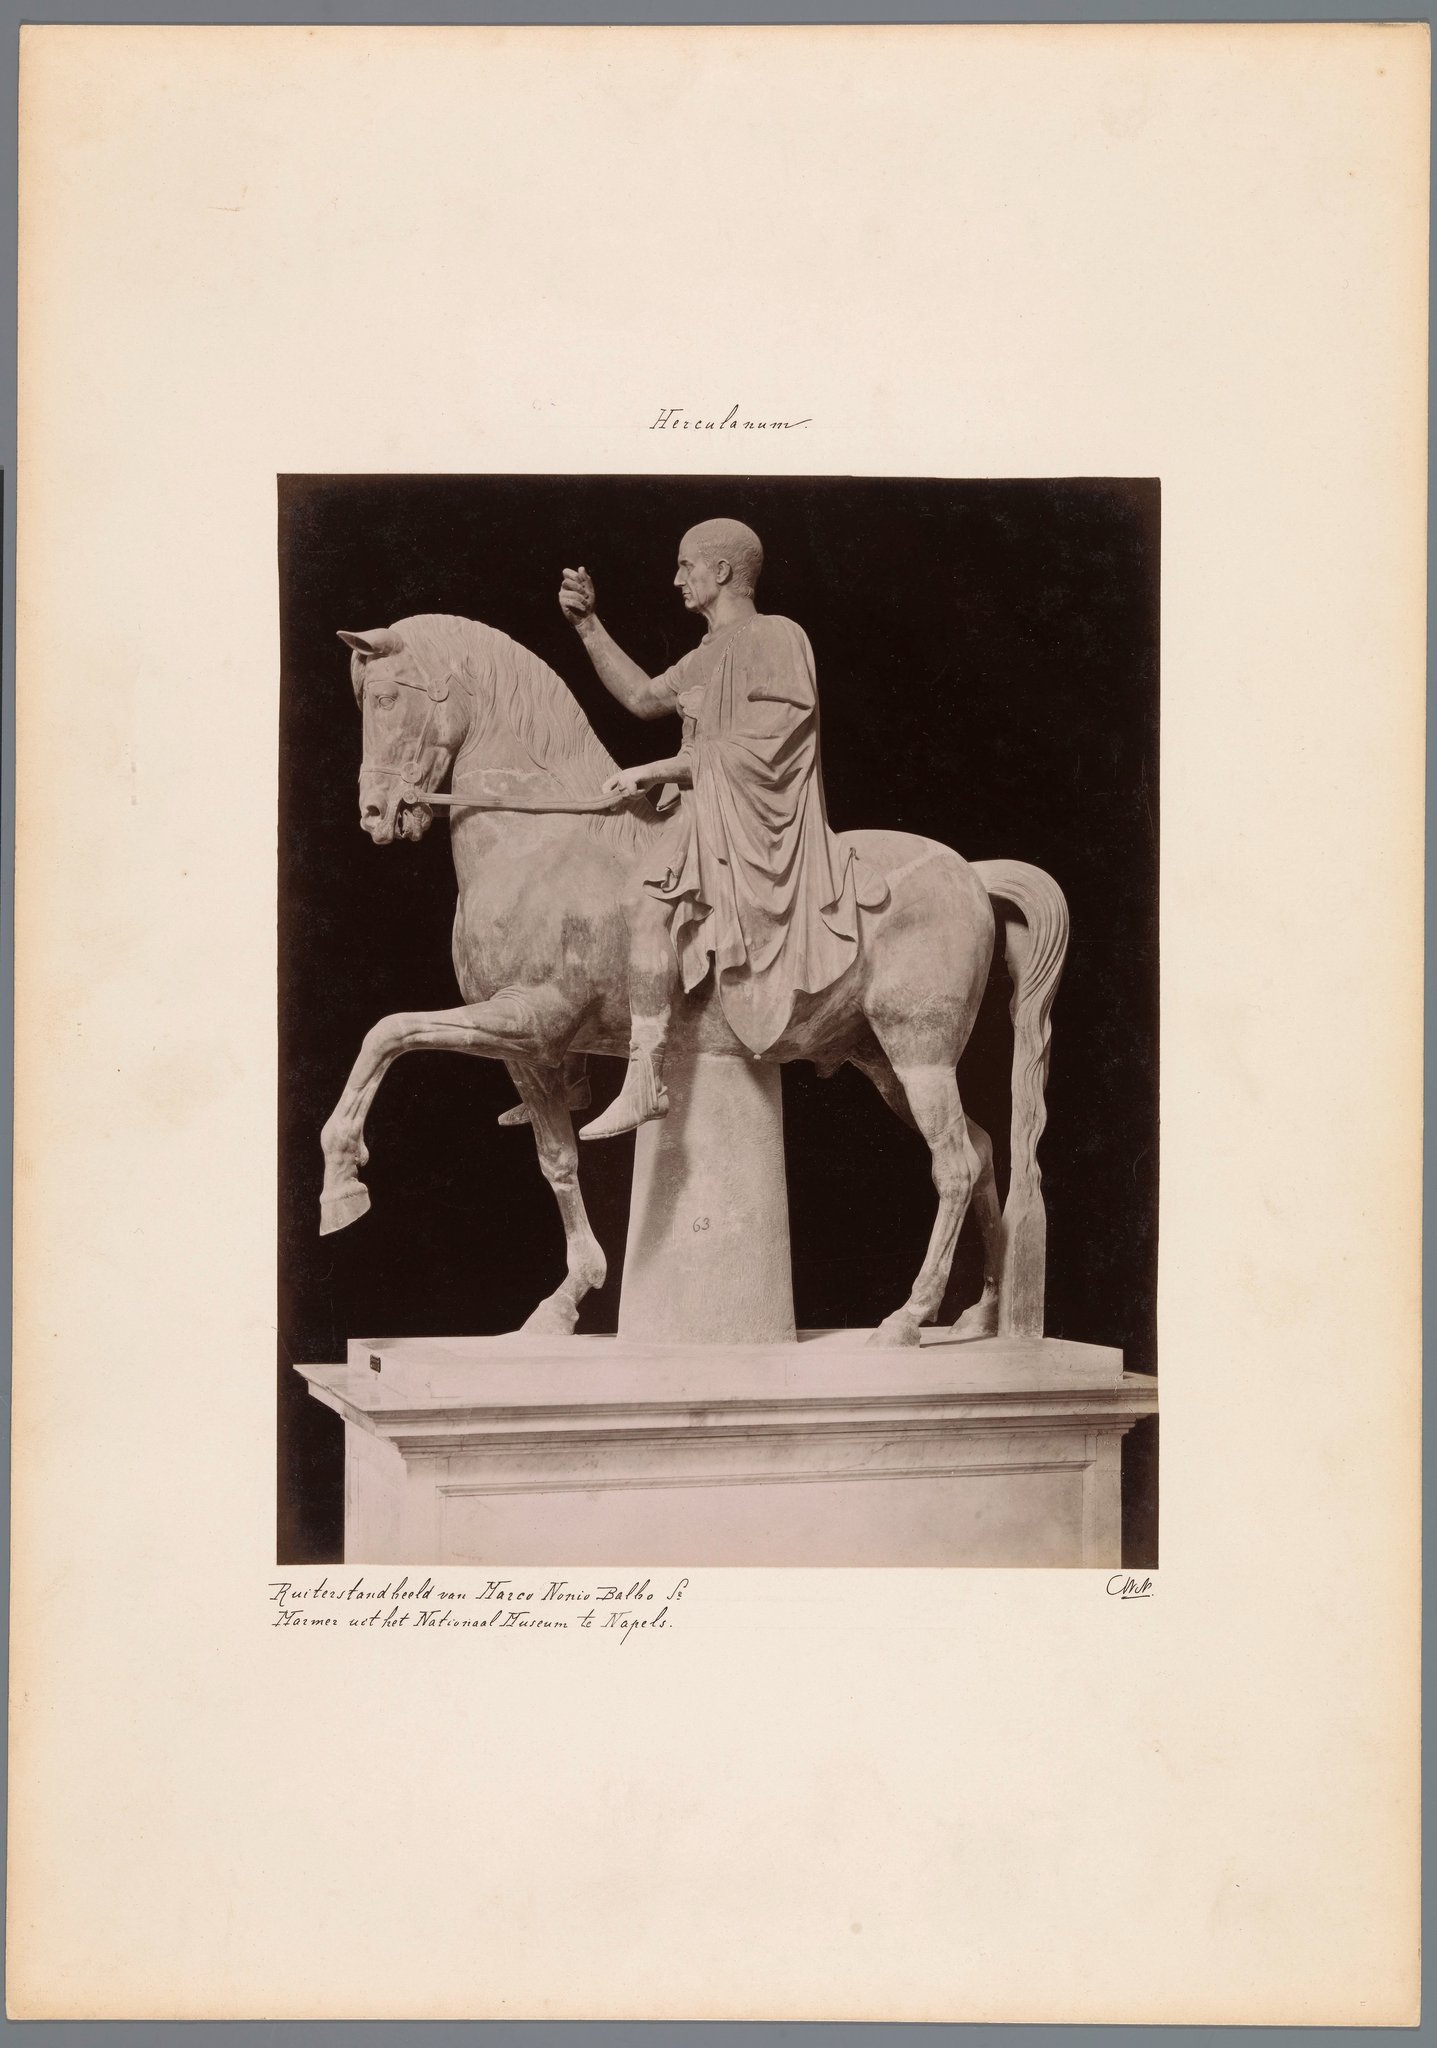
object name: photograph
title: Ruiterstandbeeld van Marco Nonio Balbo Se Marmer uit het Nationaal Museum te Napels.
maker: Anonymous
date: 1875-1900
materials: cardboard, photographic support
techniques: albumen print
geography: europe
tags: riding a horse, ass, or mule; rider, horseman, piece of sculpture, reproduction of a piece of sculpture, male persons from classical history, europe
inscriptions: collector's mark: ‘INSTITUUT VOOR KUNST-NIJVERHEIDSONDERWIJS GABRIËL METSUSTRAAT No. 16 AMSTERDAM’, collector's mark: ‘KUNSTNIJVERHEIDSCHOOL QUELLINUS AMSTERDAM FRANS HALSSTRAAT 14.’, inscription: ‘Herculanum.’, inscription: ‘CWN.’